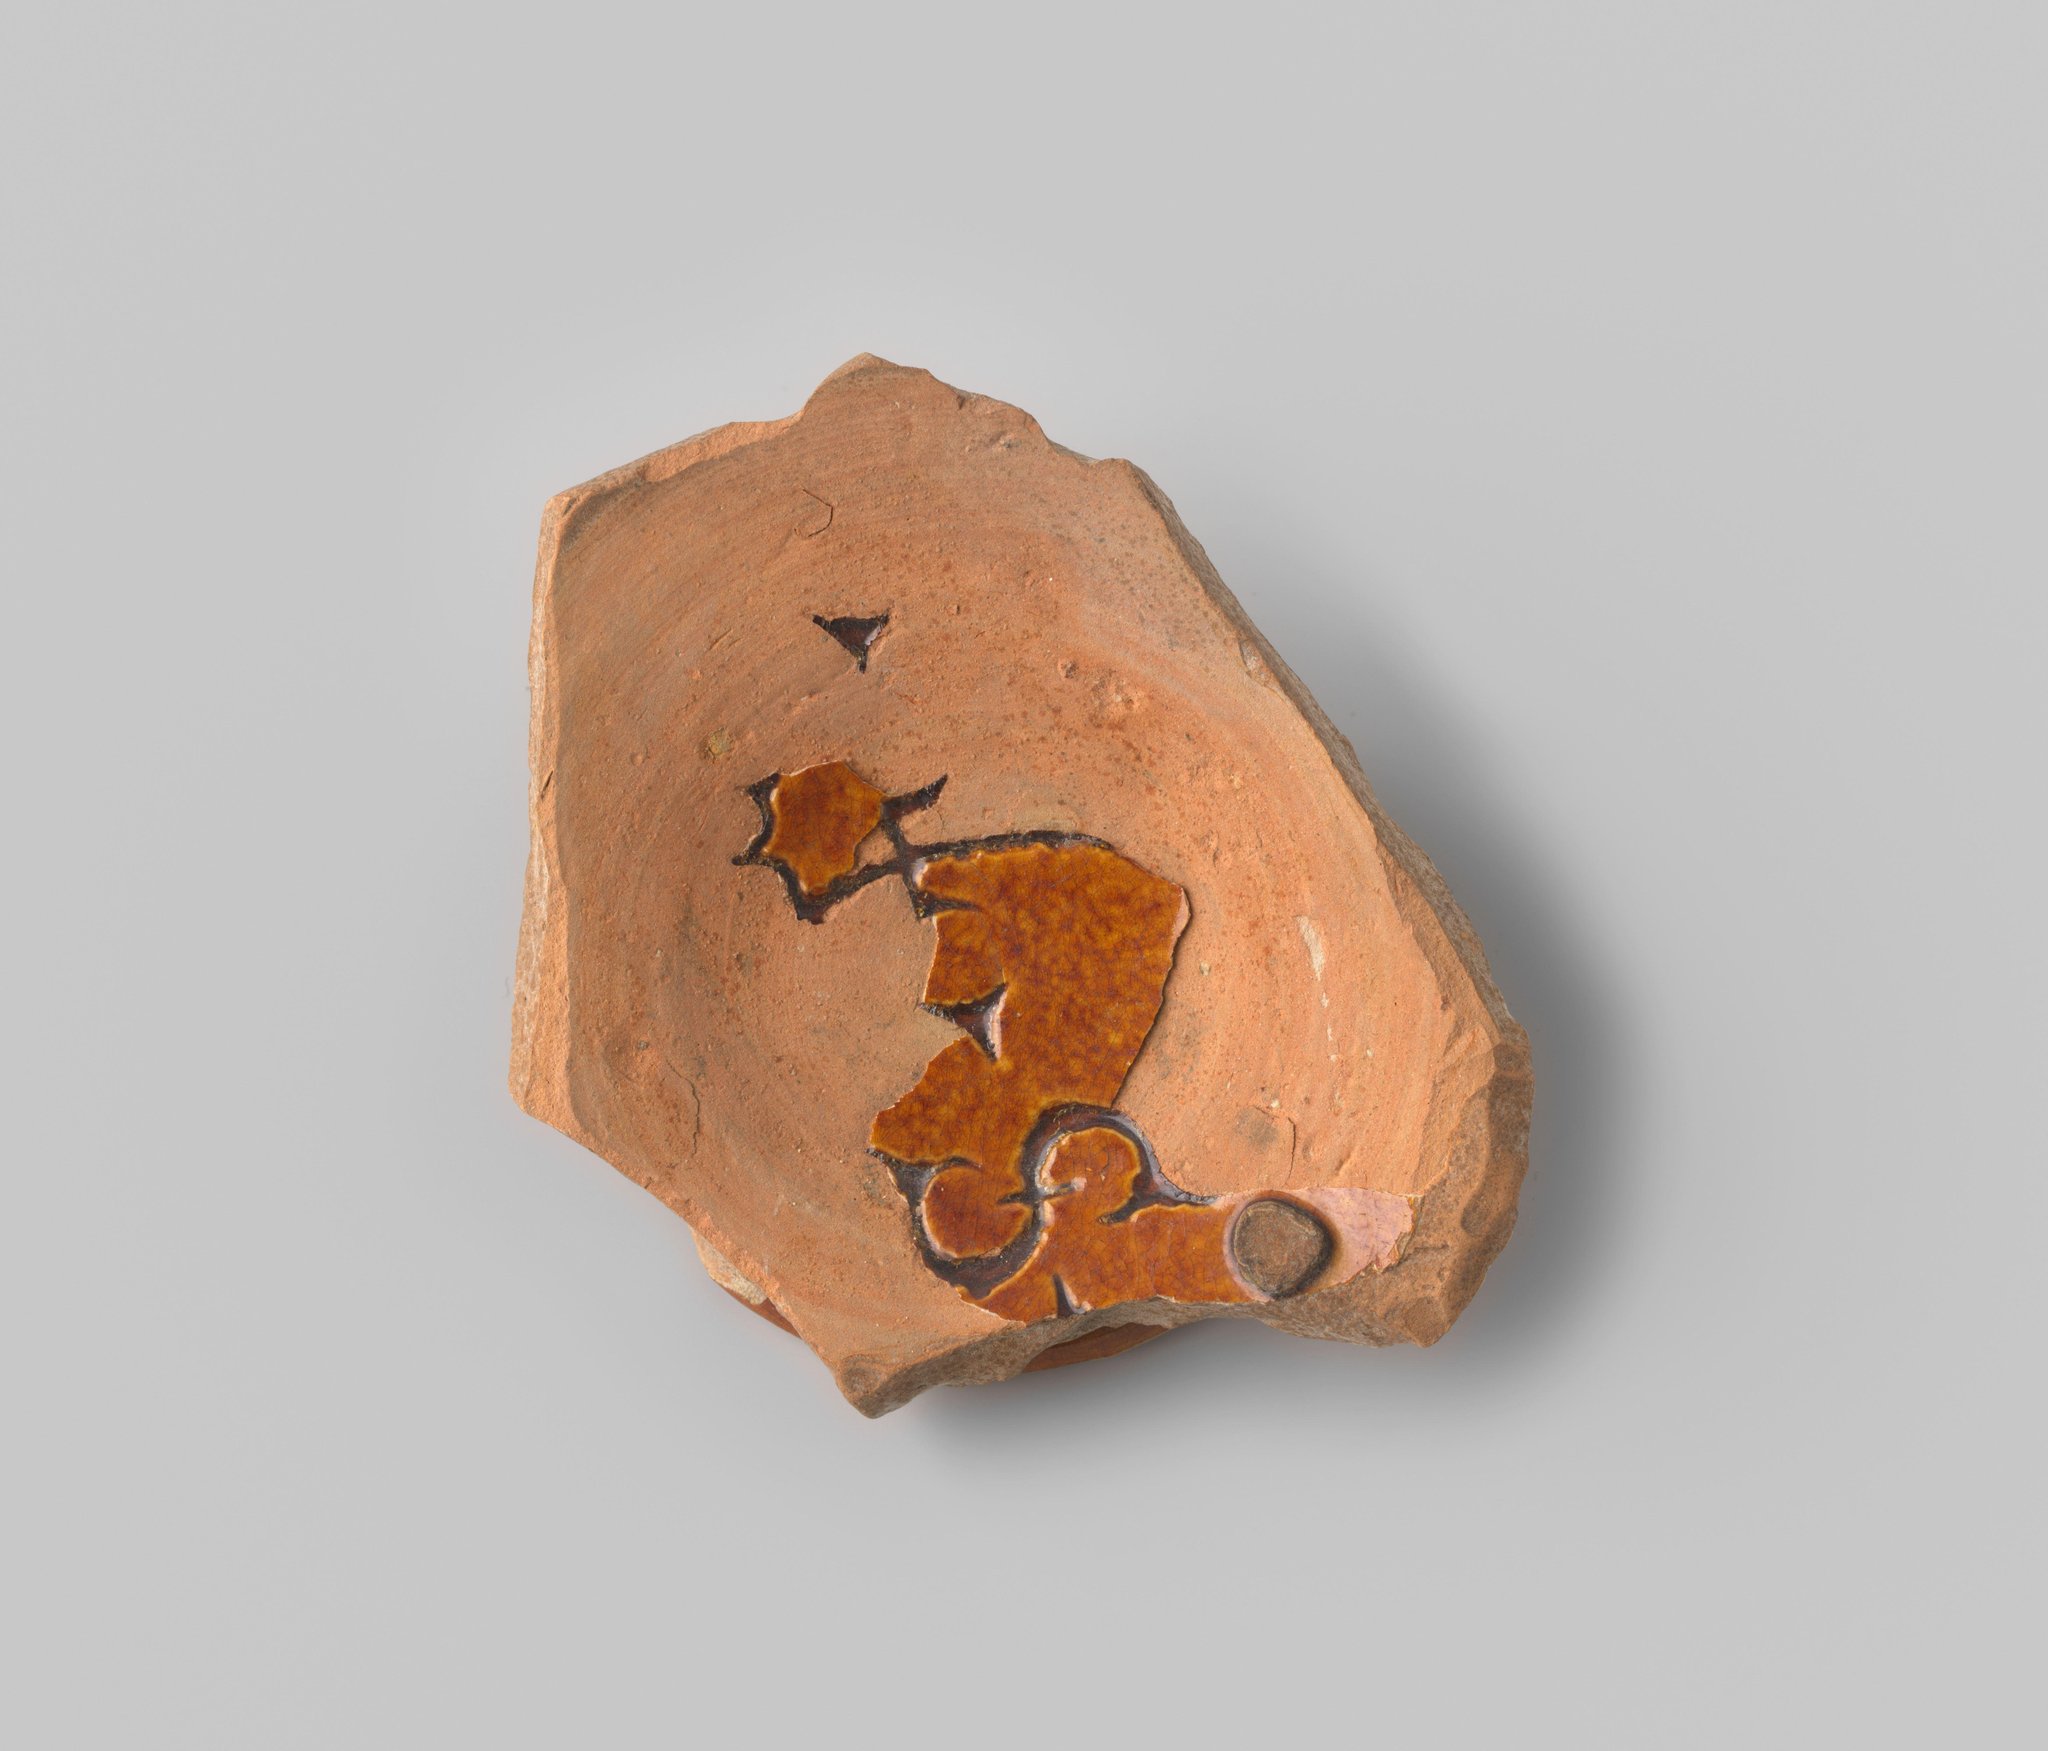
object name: sherd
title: Fragment (voet) met rode scherf, in de bodem gegrift letters gelijkend op ϮS (of omgekeerd), bruin hazevelachtig glazuur dat erg bladdert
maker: Anonymous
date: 1200-1899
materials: earthenware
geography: italy